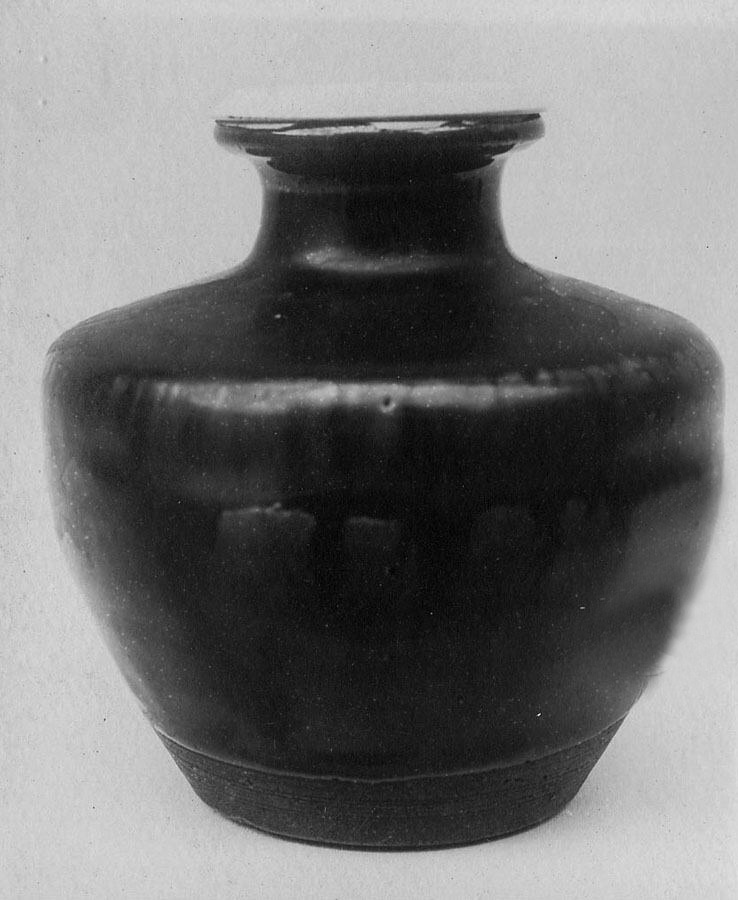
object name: tea jar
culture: japanese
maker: tôshiro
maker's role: artist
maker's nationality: japanese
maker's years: 1200-1230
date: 1320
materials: clay, glaze